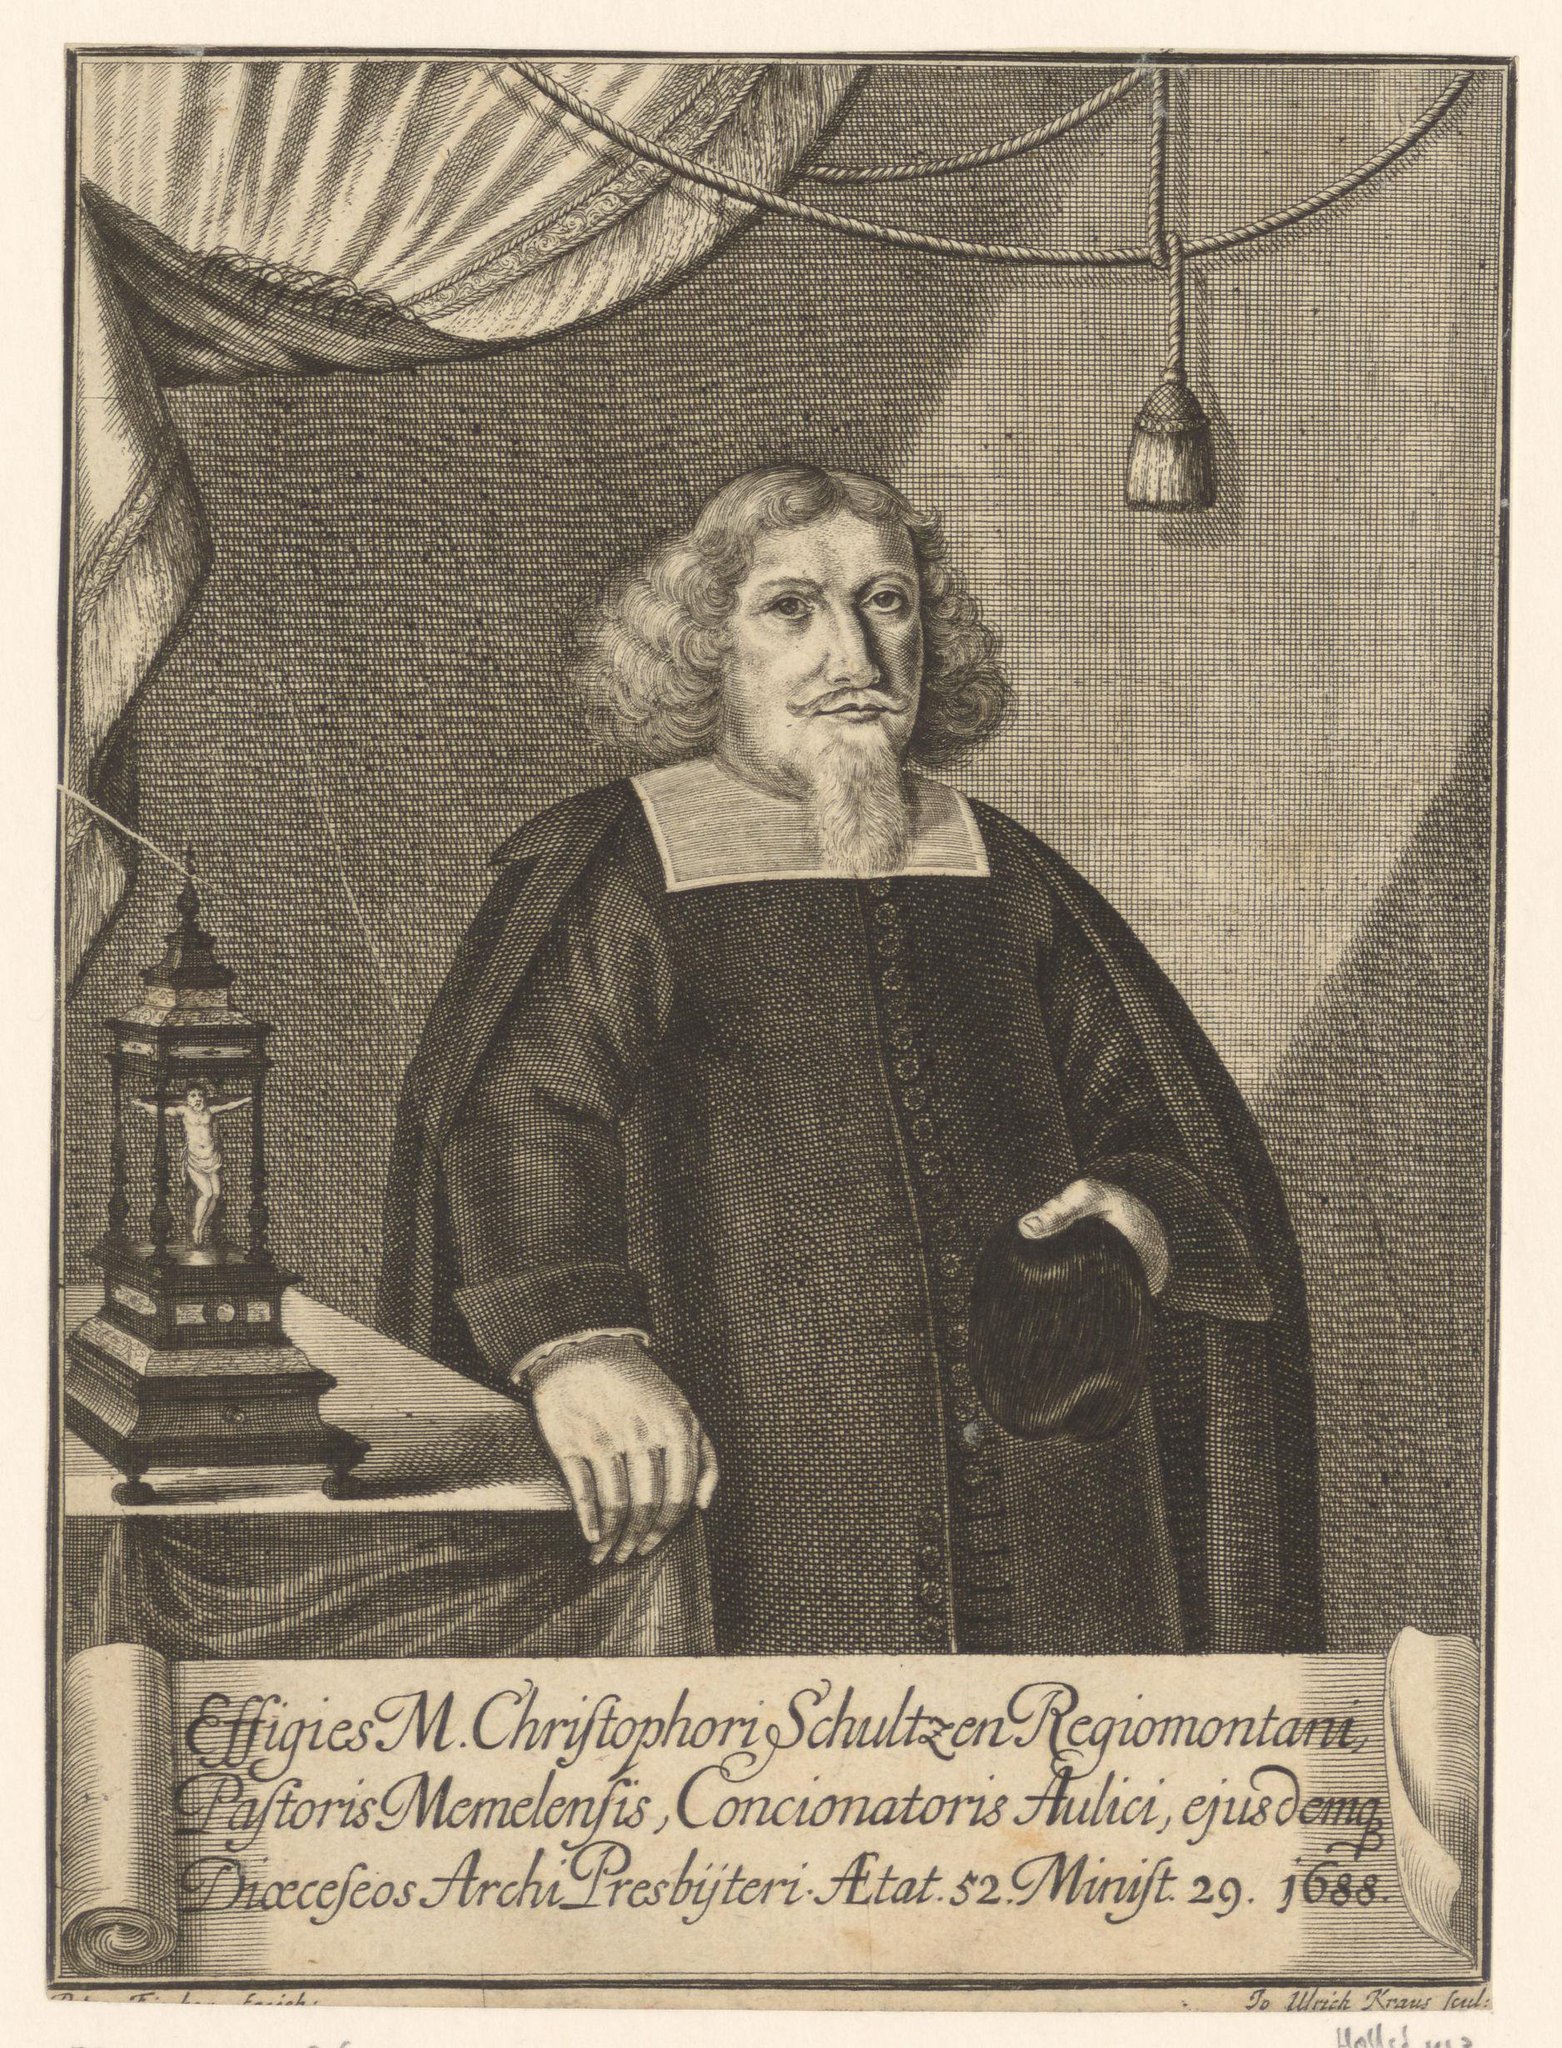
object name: print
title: Portret van Christoph Schultze op 52-jarige leeftijd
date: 1688-1719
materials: paper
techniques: engraving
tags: theologian, historical persons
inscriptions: collector's mark: Lugt 2228